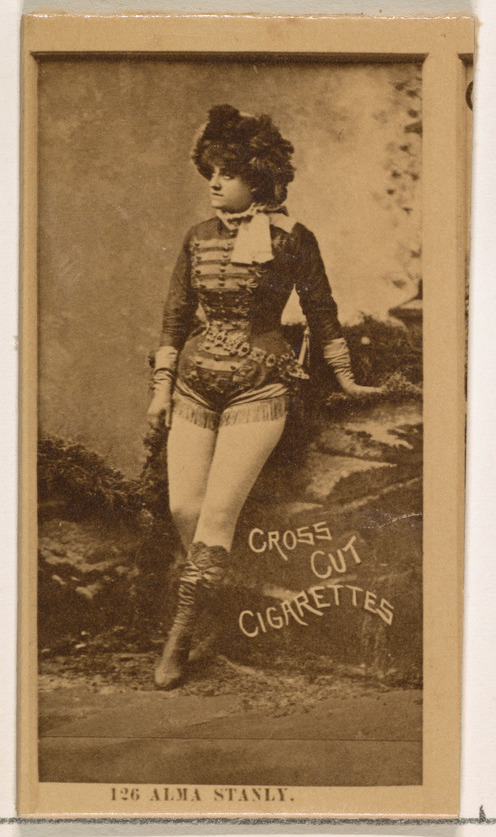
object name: print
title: Card Number 126, Alma Stanley, from the Actors and Actresses series (N145-2) issued by Duke Sons & Co. to promote Cross Cut Cigarettes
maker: w. duke, sons & co.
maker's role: publisher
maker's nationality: american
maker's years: 1870-1920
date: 1880-1889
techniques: albumen silver print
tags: portraits,women,actresses